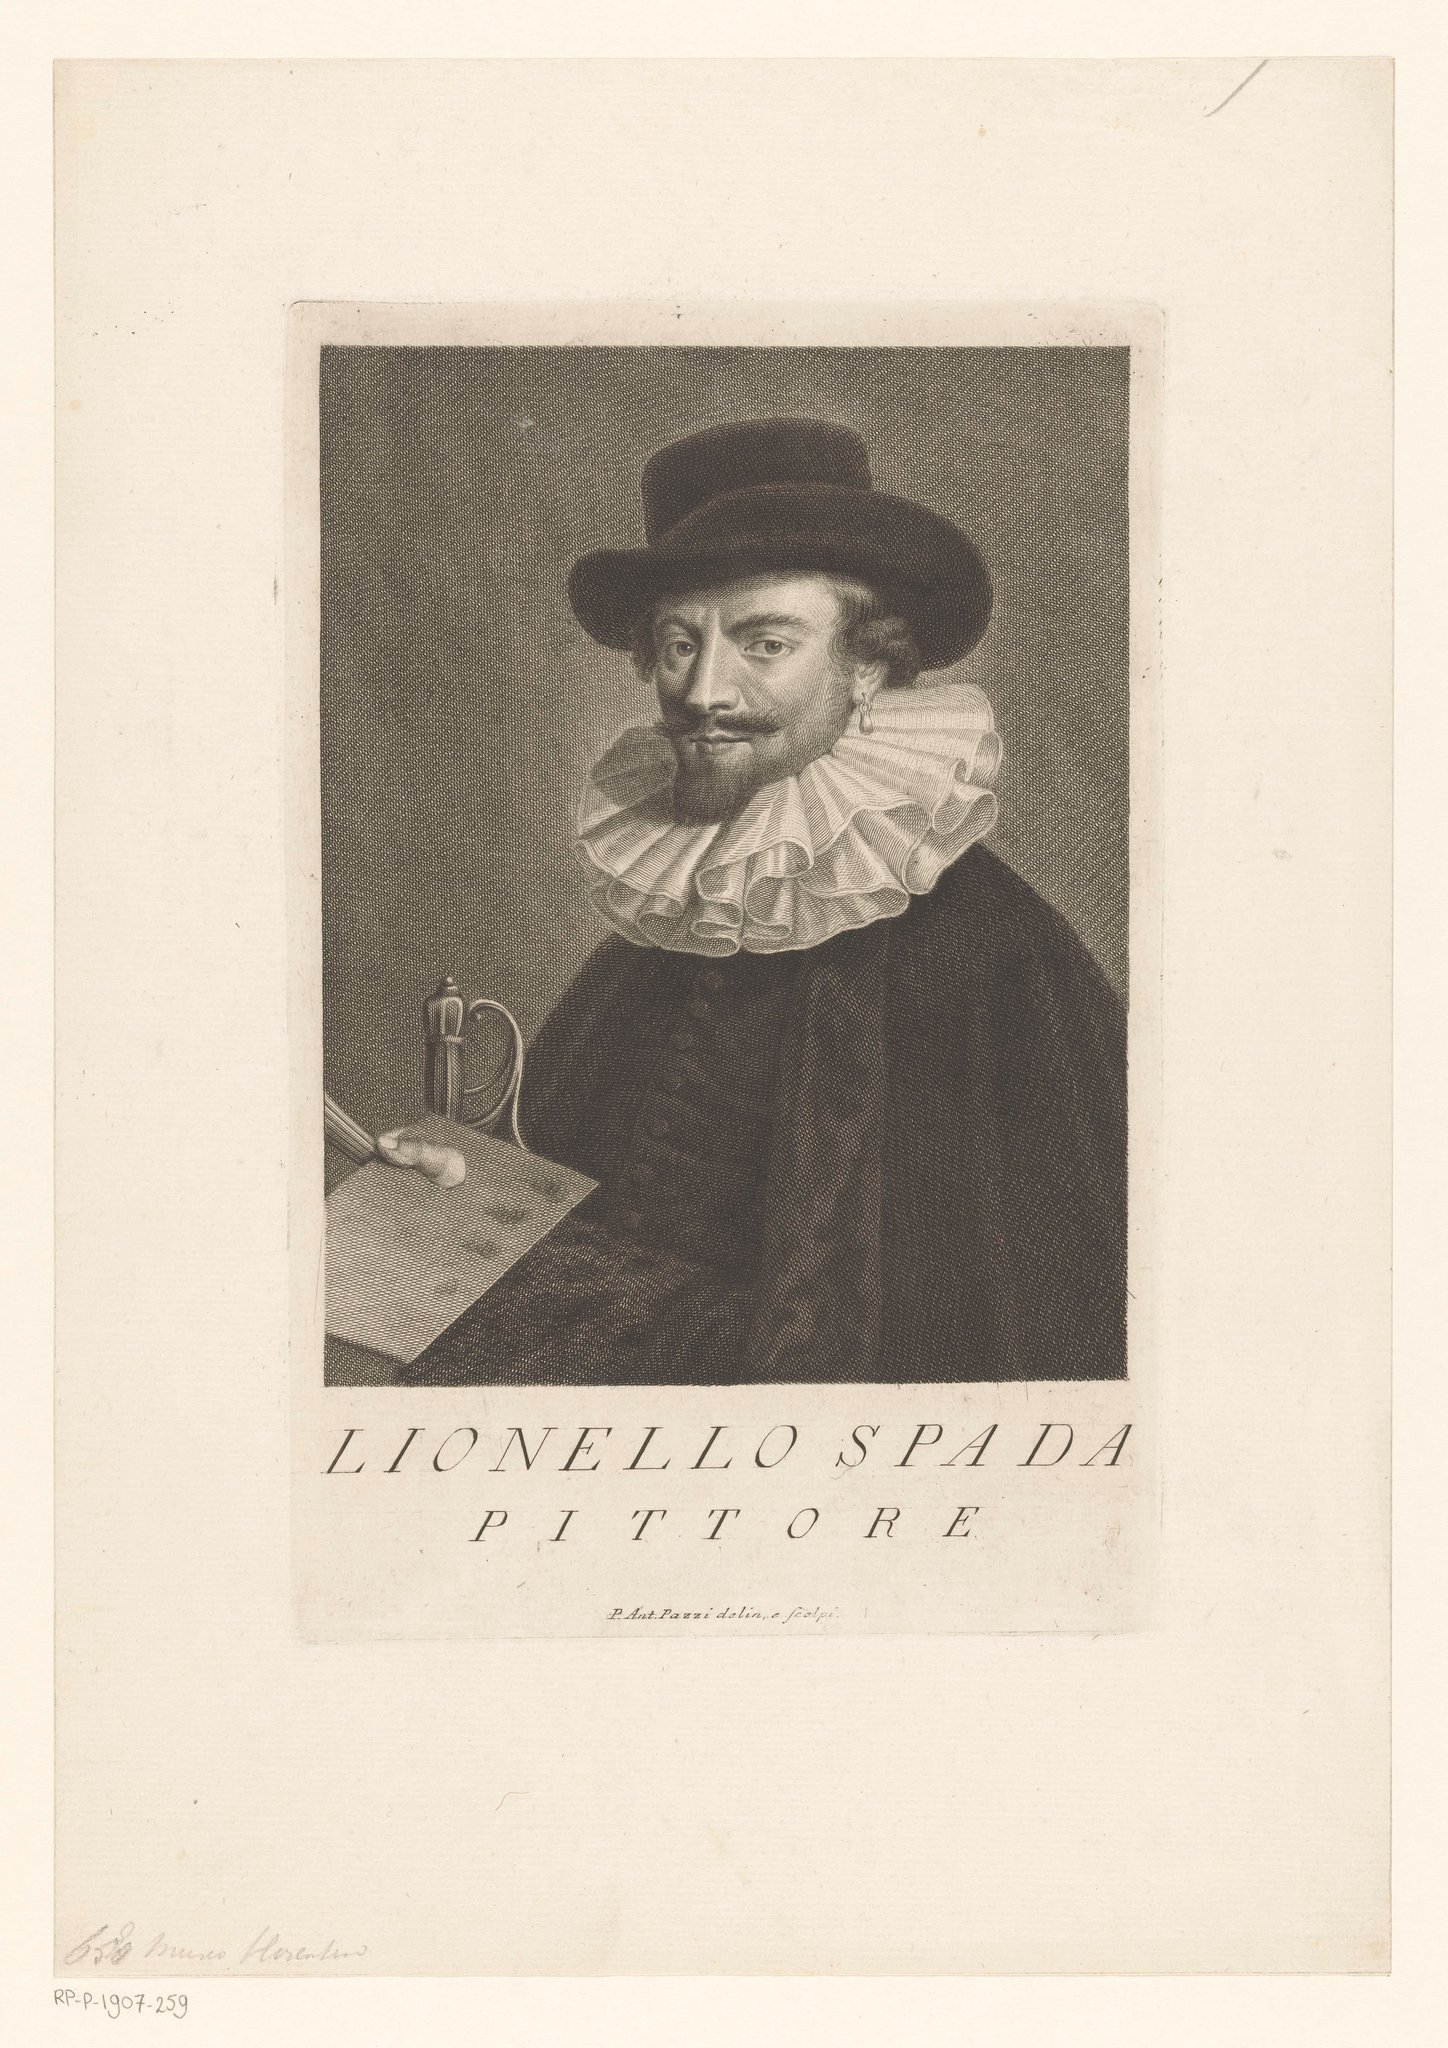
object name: book illustration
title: Portret van kunstenaar Leonello Spada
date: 1752-1762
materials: paper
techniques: engraving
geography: italy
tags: draughtsman, lionello spada, historical persons, portrait, self-portrait of painter, tools, implements of painter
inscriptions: collector's mark: Lugt 2228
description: Prent mogelijk naar een zelfportret van Leonello Spada. Prent uit: Moücke, Francesco. Serie di ritratti degli eccellenti pittori dipinti di propria mano, che esistono nell'Imiperial Galleria di Firenze. Florence: 1752-1762.